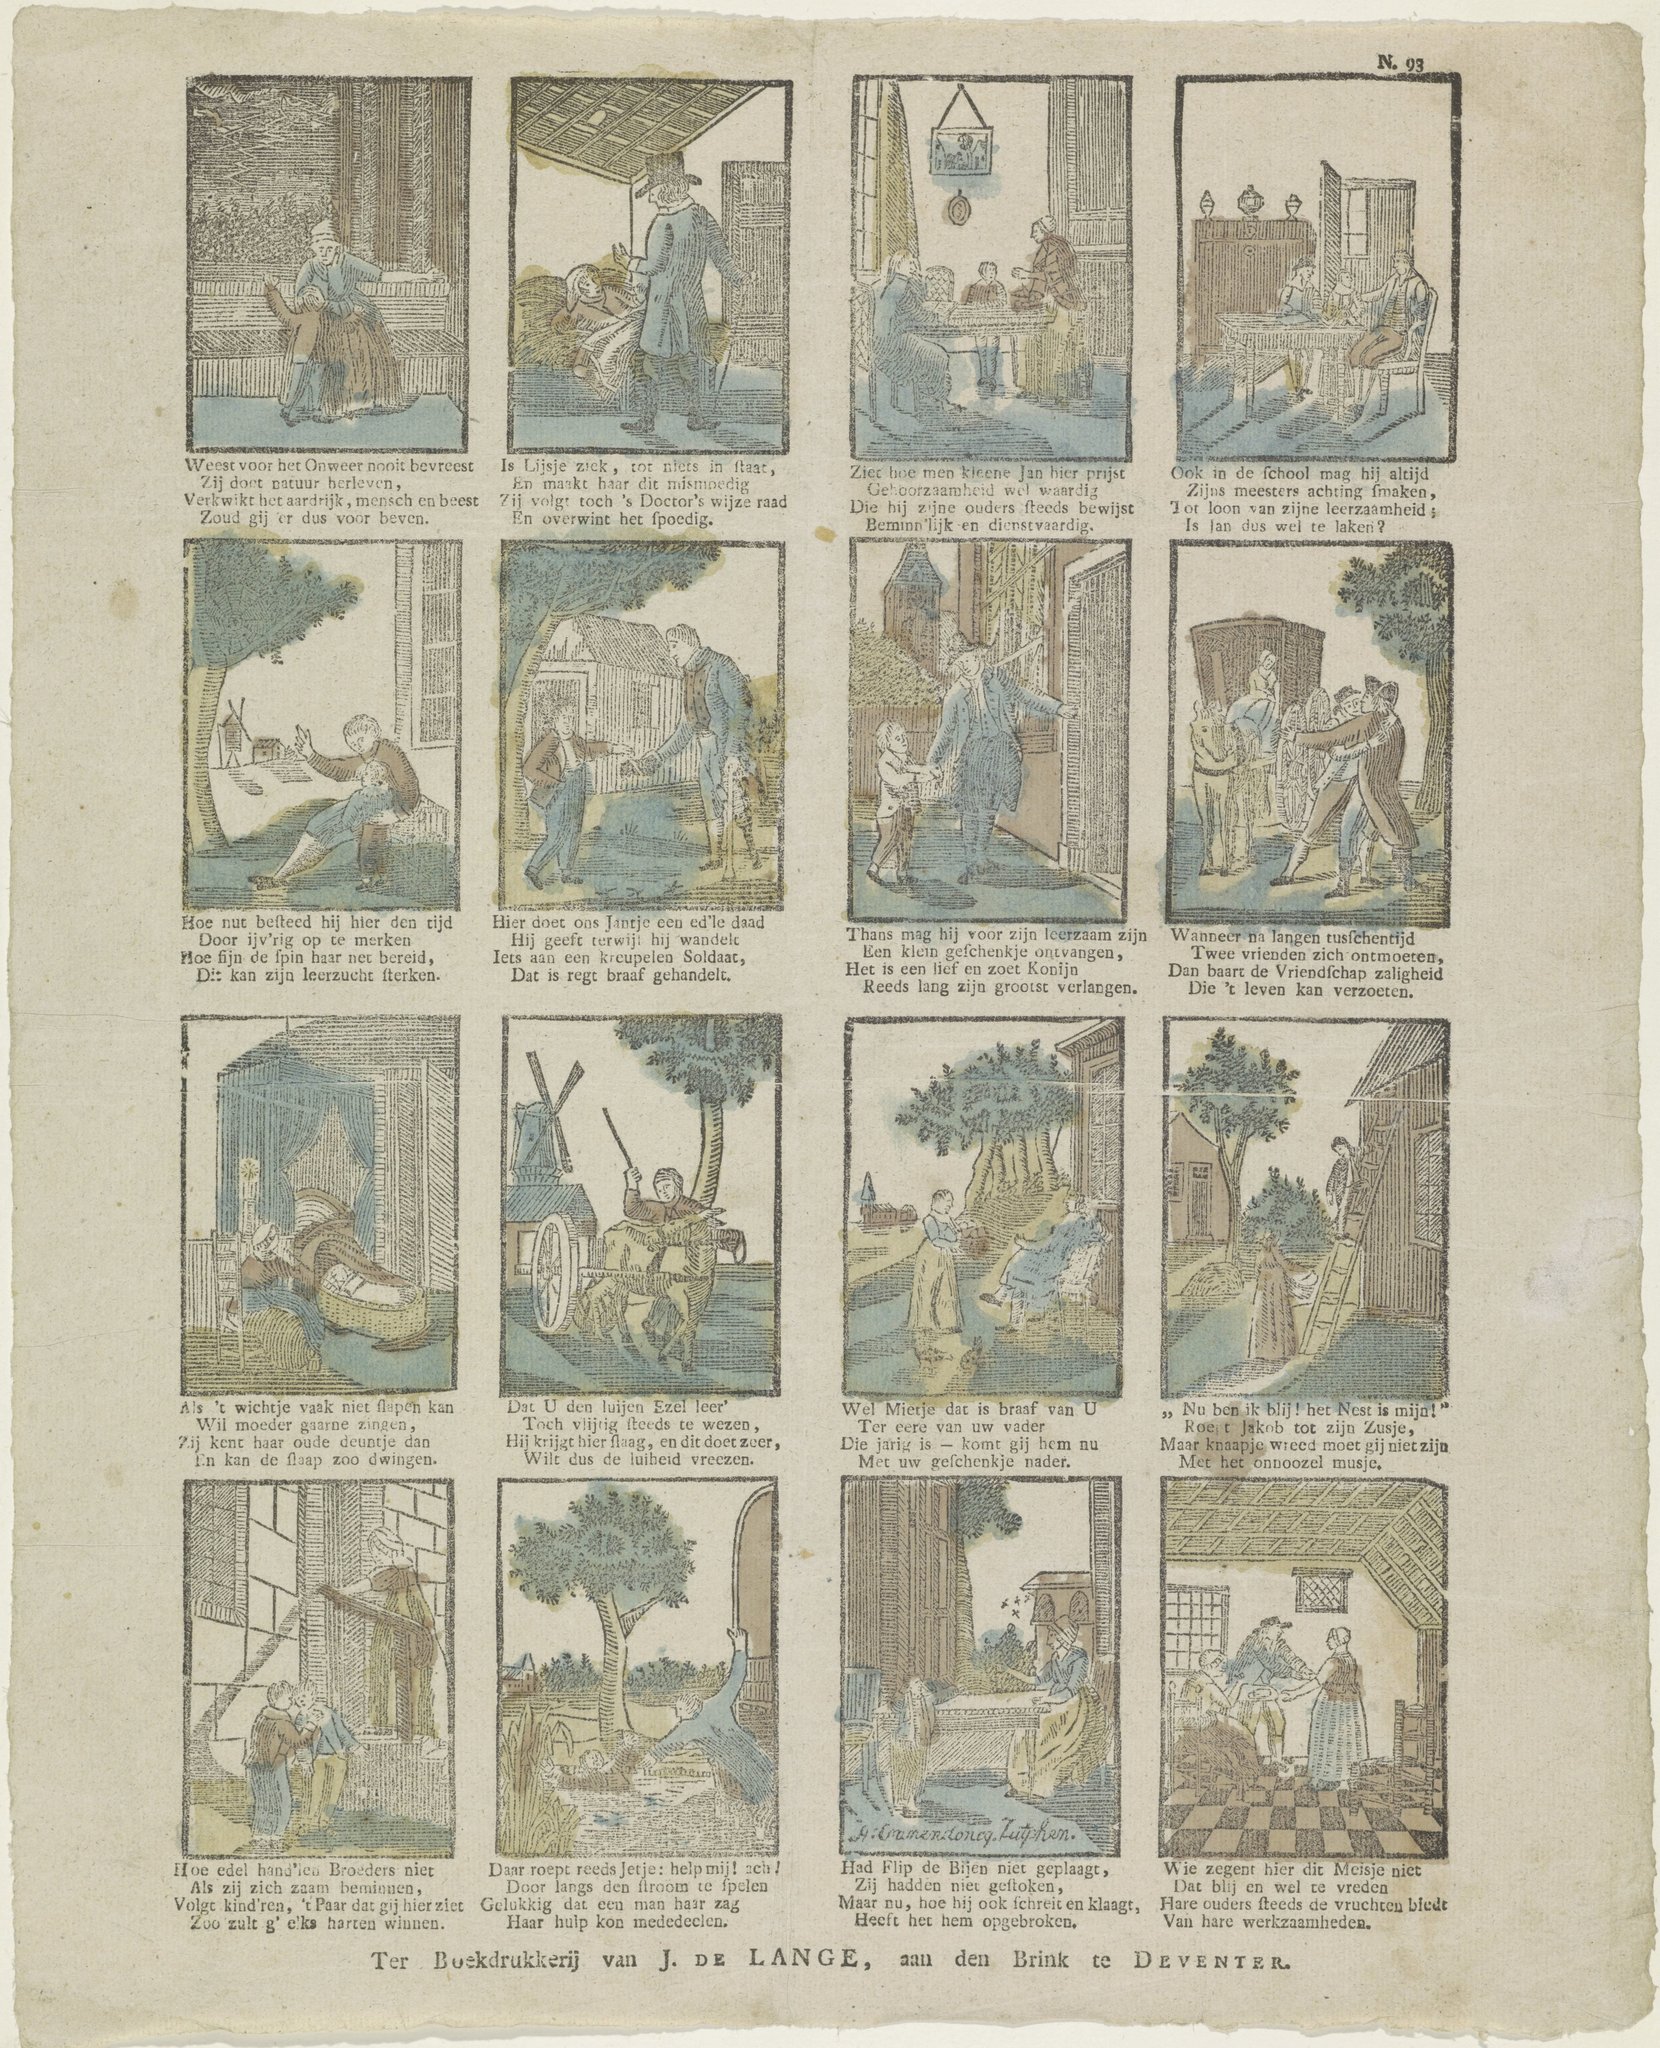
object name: popular print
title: Kinderleven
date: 1822-1849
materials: paper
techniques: colour, letterpress printing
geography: zutphen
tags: child, four-wheeled, animal-drawn vehicle, e.g.: cab, carriage, coach, physician, doctor, thunderstorm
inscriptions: collector's mark: Lugt 2760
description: Blad met 16 voorstellingen van verschillende aard, waaronder taferelen uit het kinderleven. Onder elke afbeelding een vierregelig vers. Genummerd rechtsboven: N. 93.